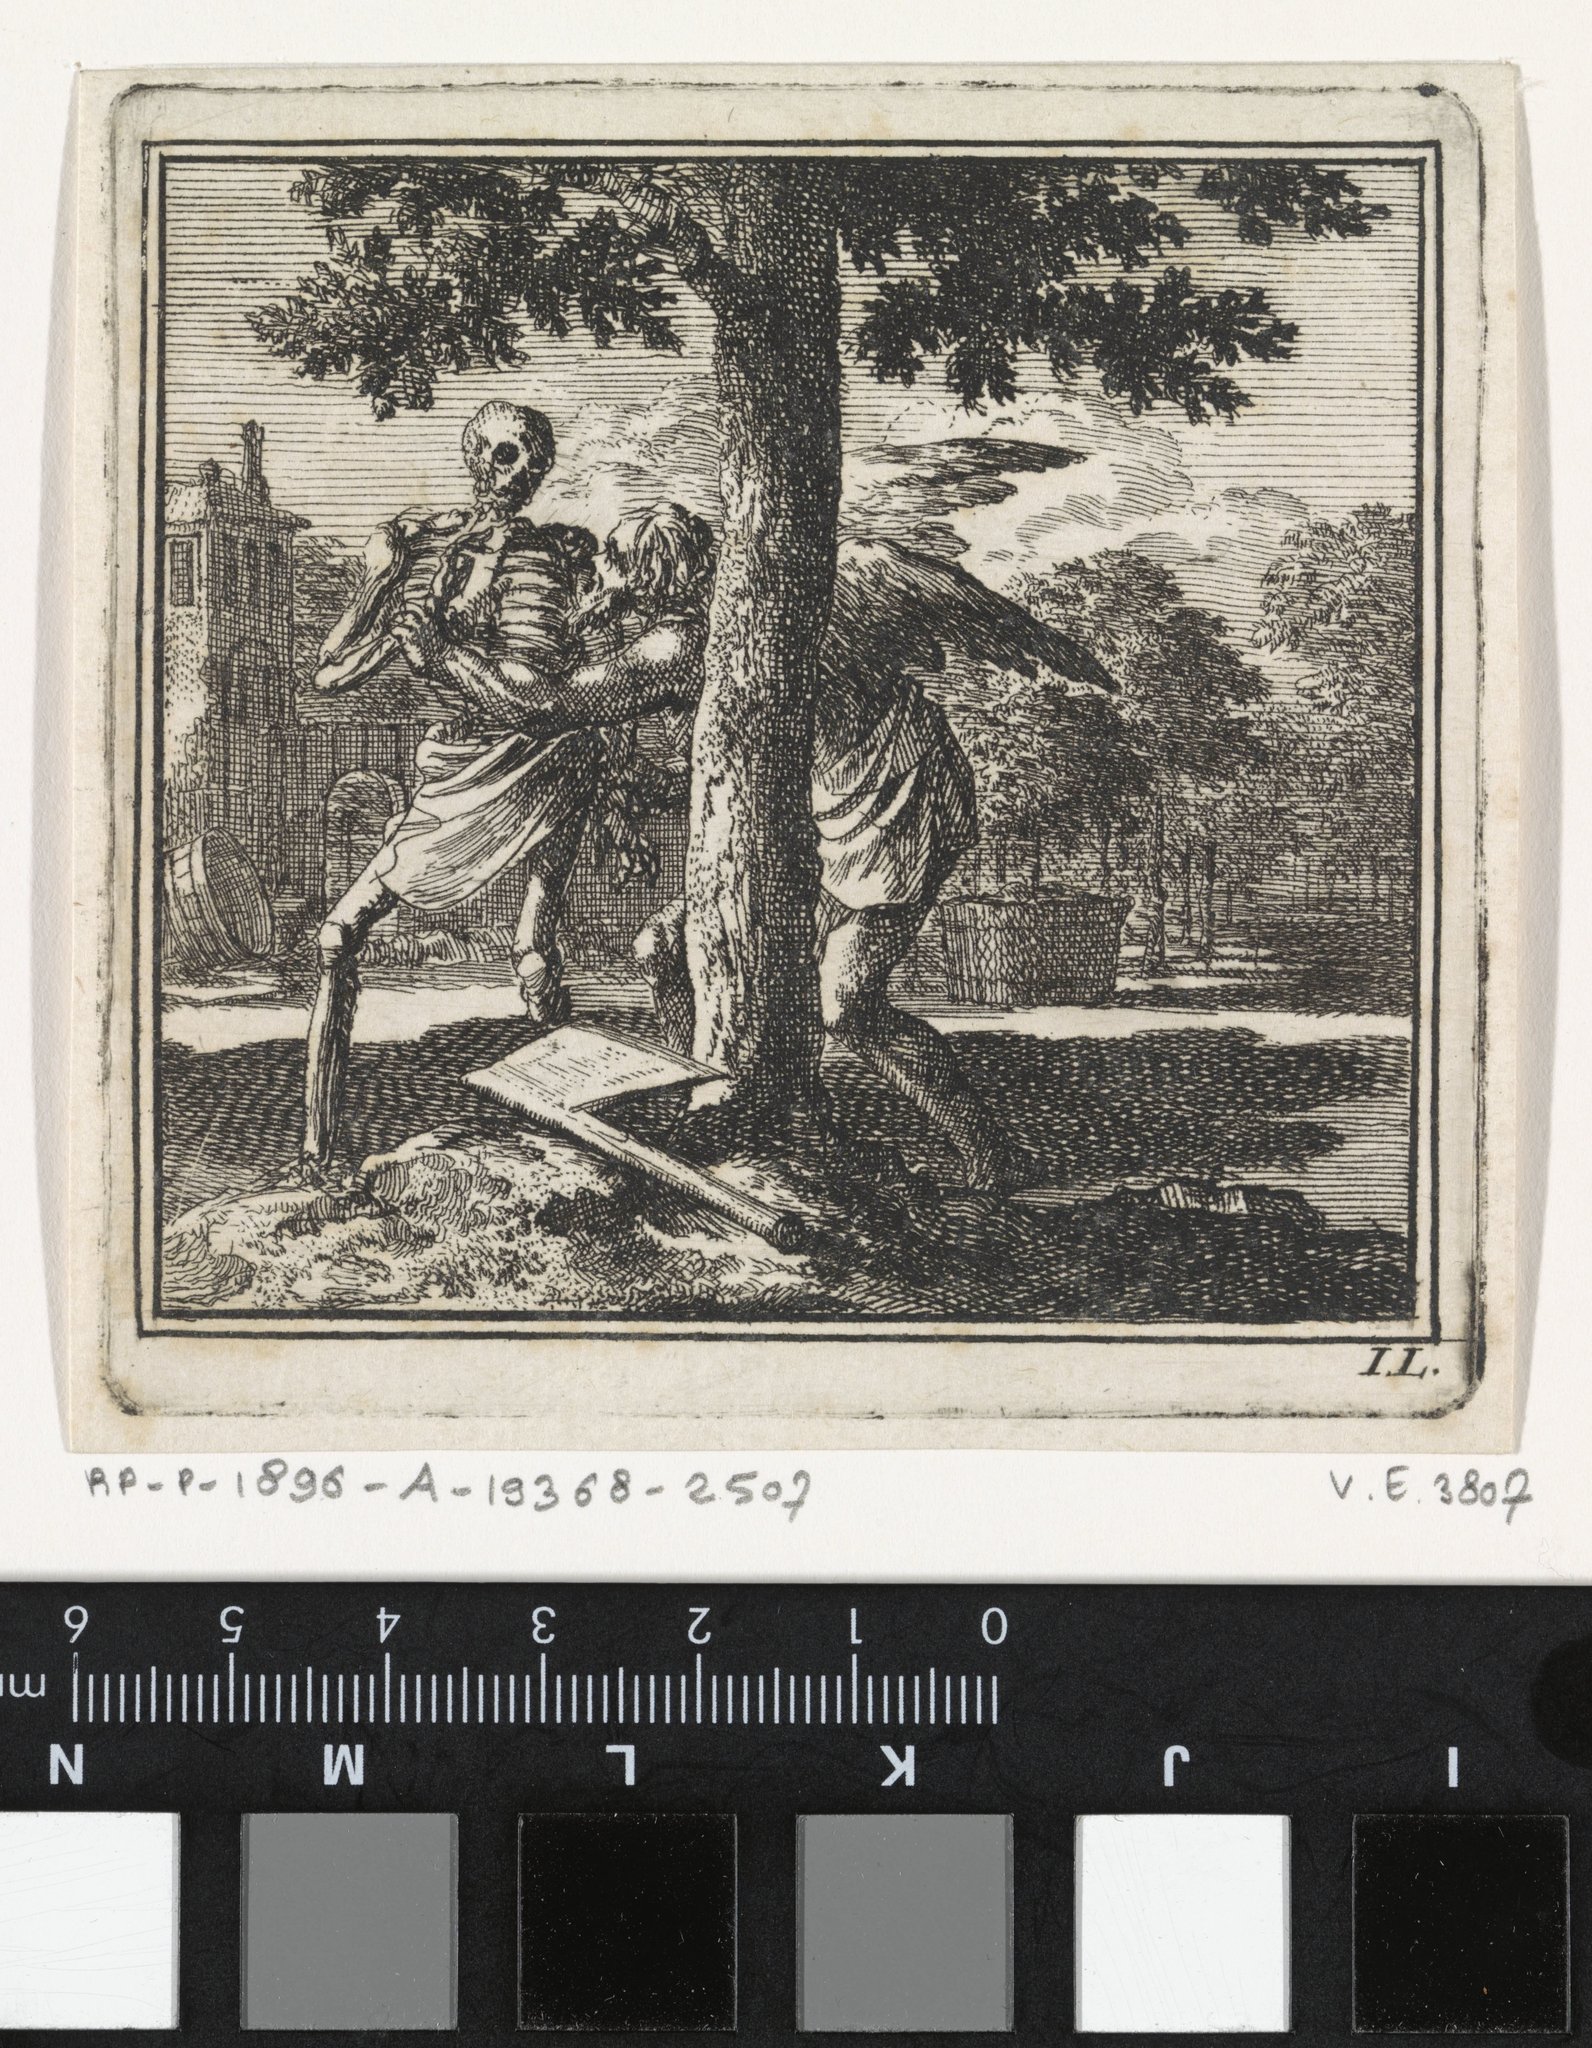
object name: book illustration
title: Vader Tijd weerhoudt de dood ervan een boom om te hakken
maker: jan luyken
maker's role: draughtsman, print maker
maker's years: 1649-1712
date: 1710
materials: paper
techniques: etching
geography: amsterdam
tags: trees, father time, man with wings and scythe, death as skeleton - ff - death as female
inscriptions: collector's mark: Lugt 2228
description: Illustratie uit: Luyken, Jan. De onwaardige wereld, vertoond in vyftig zinnebeelden, met godlyke spreuken en stichtelyke verzen. Amsterdam: Pieter Arentsz. II (wed.) en Cornelis van der Sys, 1710, p. 42.